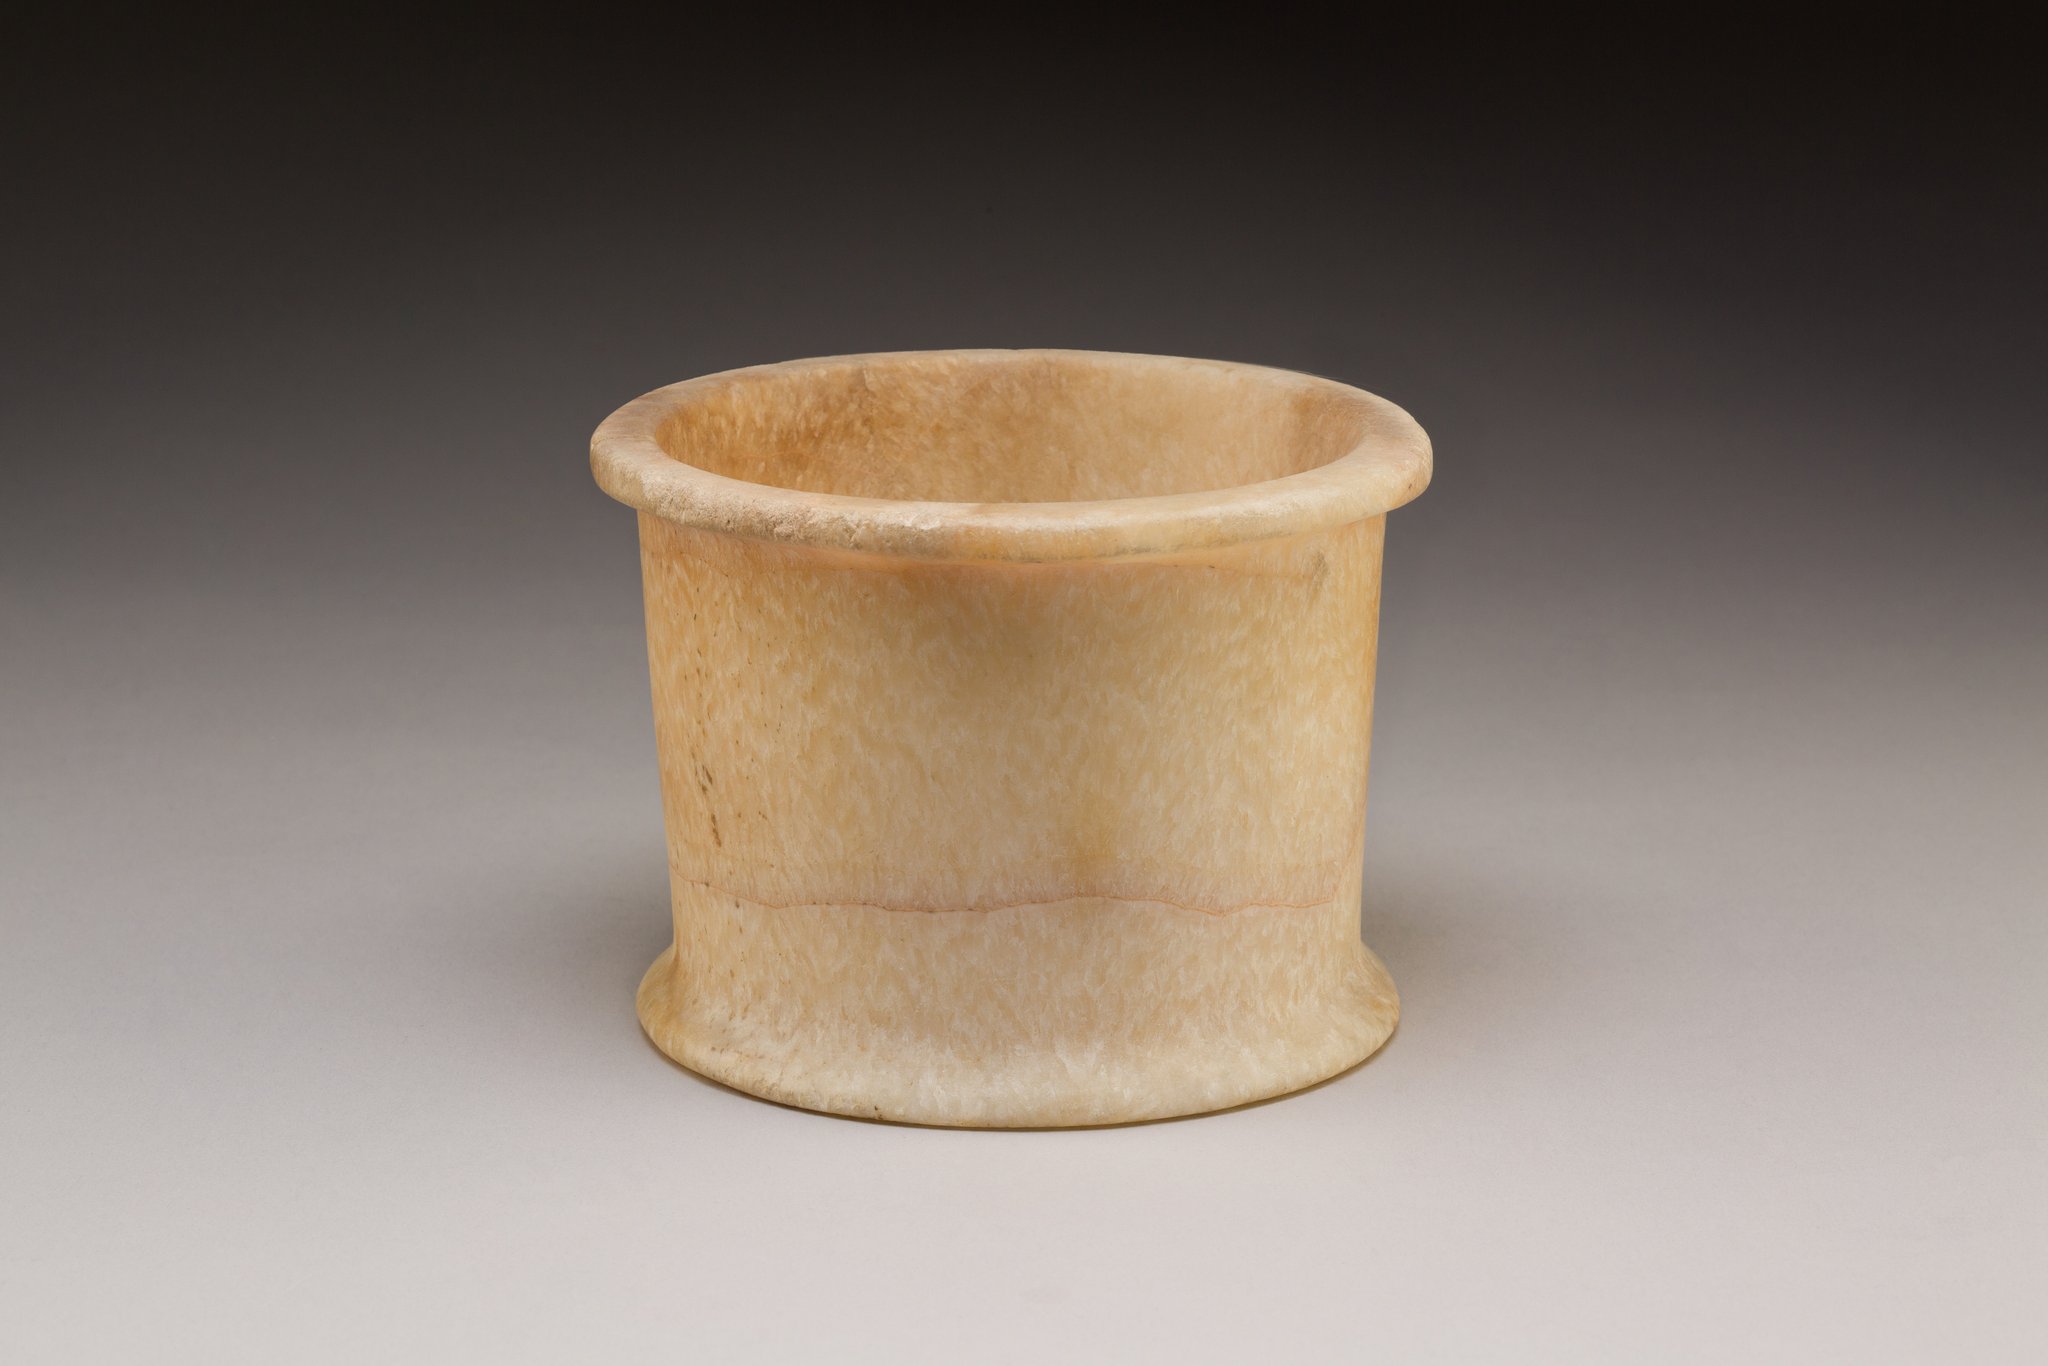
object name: cup, baki, cylindrical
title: small Cylindrical Jar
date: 1504-1447 BCE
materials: stone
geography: egypt